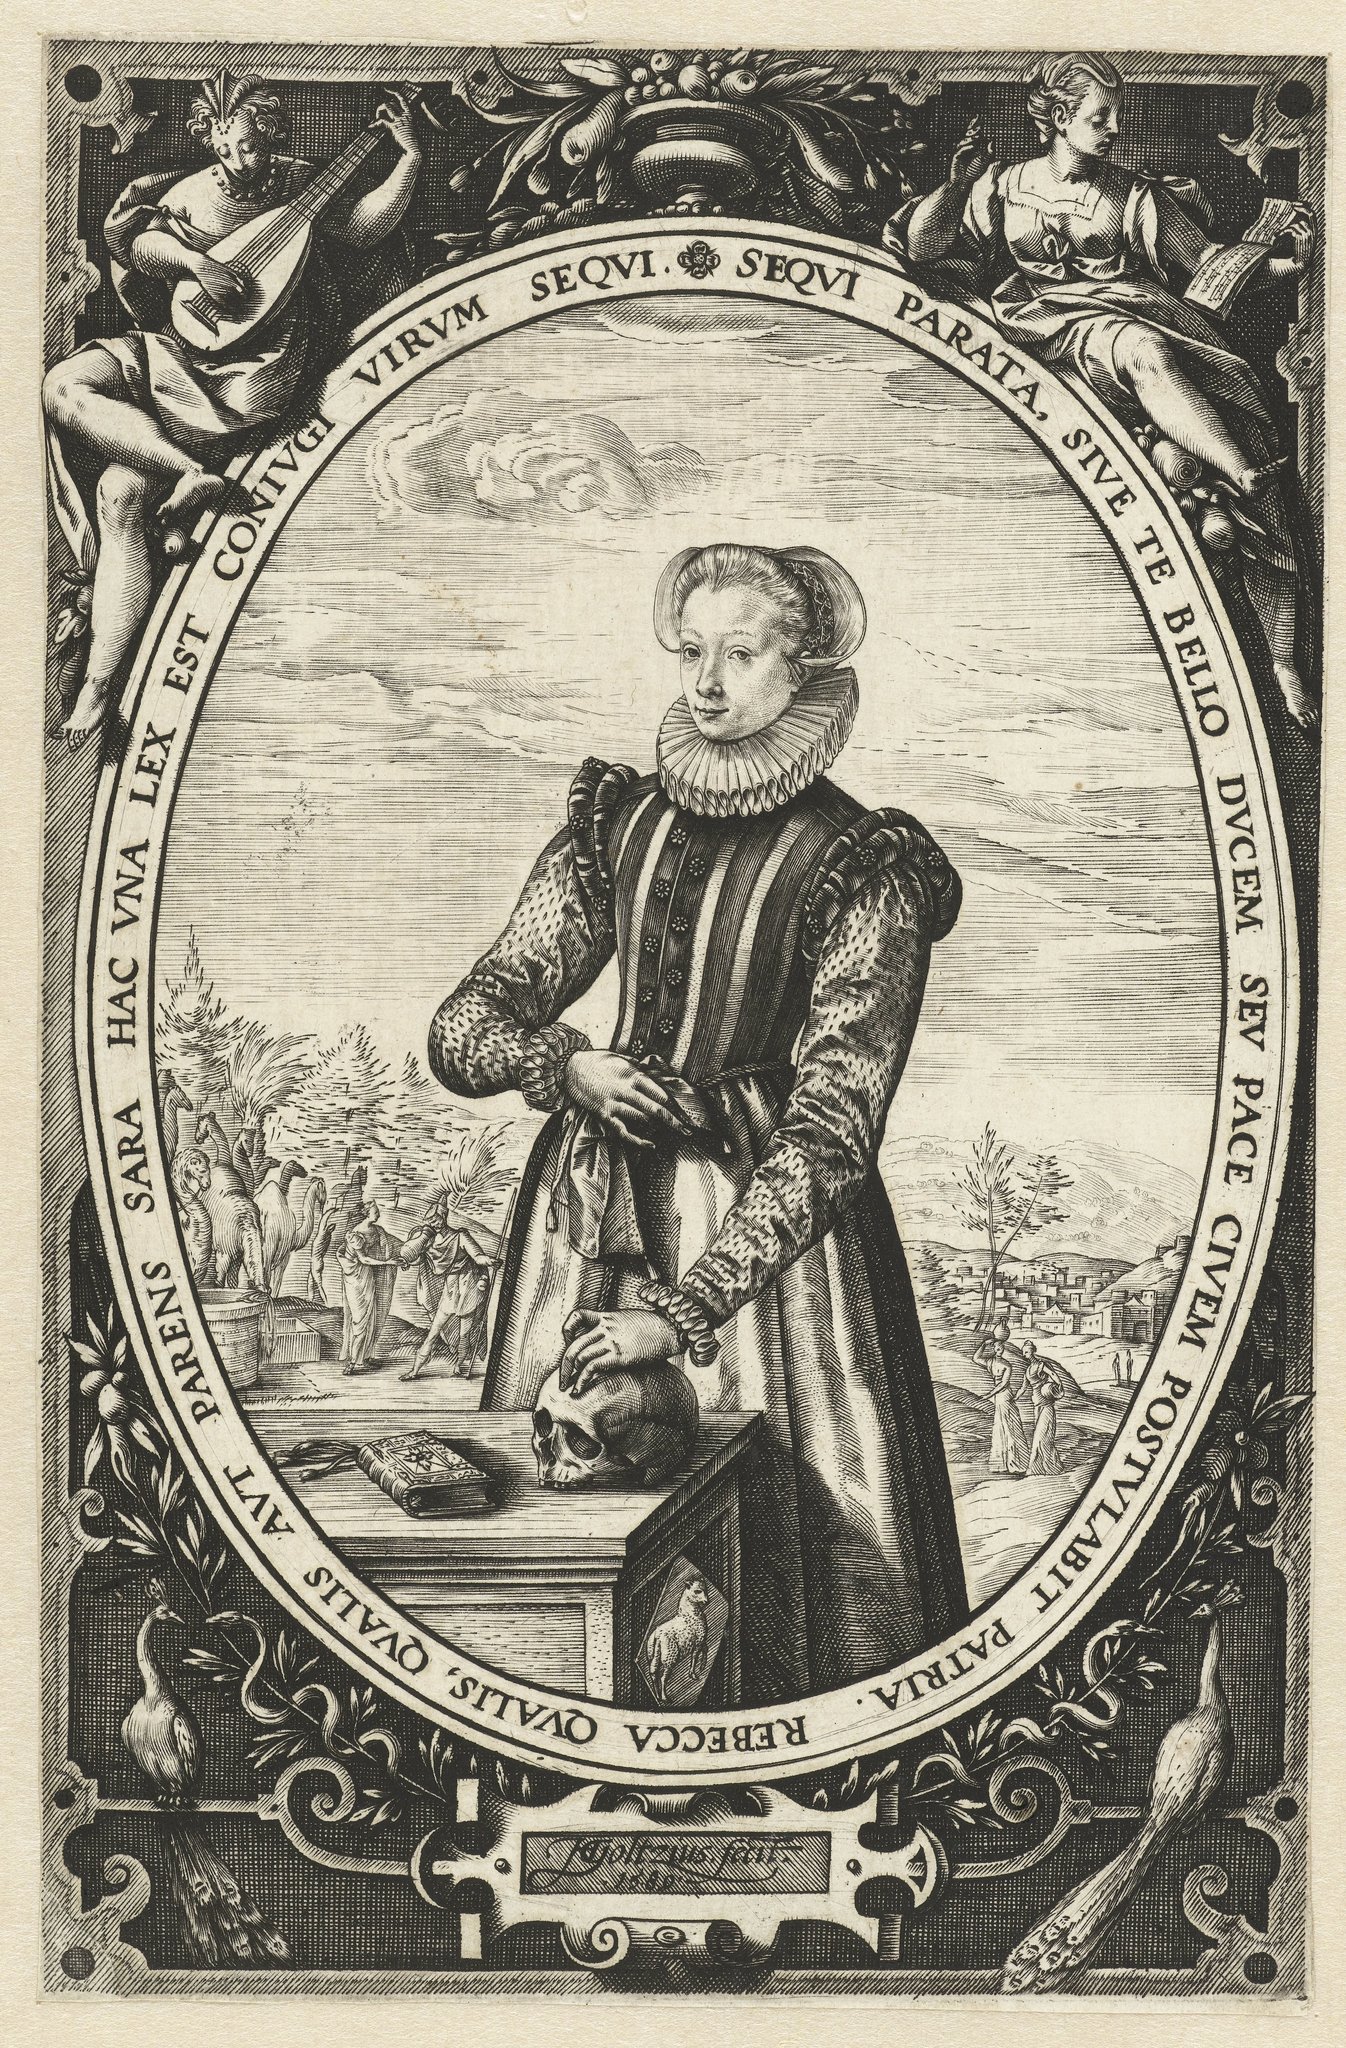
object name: print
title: Portret van Josina Hamels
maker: hendrick goltzius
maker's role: draughtsman, painter, print maker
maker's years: 1558-1617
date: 1580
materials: paper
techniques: engraving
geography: haarlem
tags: historical persons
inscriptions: collector's mark: Lugt 240, signature and date: ‘HGoltzius fecit 1580’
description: Portret van Josina Hamels (ca. 1560-1630), echtgenote van Jacques de la Faille. Kniestuk, staand achter tafel waarop een boek en doodshoofd. De linkerhand rust op het doodshoofd, in de rechterhand een zakdoek met kwastjes. In ovaal met randschrift. Het ovaal zelf weer in ornamentale omlijsting waarin bovenaan twee dames, een met muziekboek en een met luit. Onderaan twee pauwen. Pendant van portret van echtgenoot Jacques de la Faille.